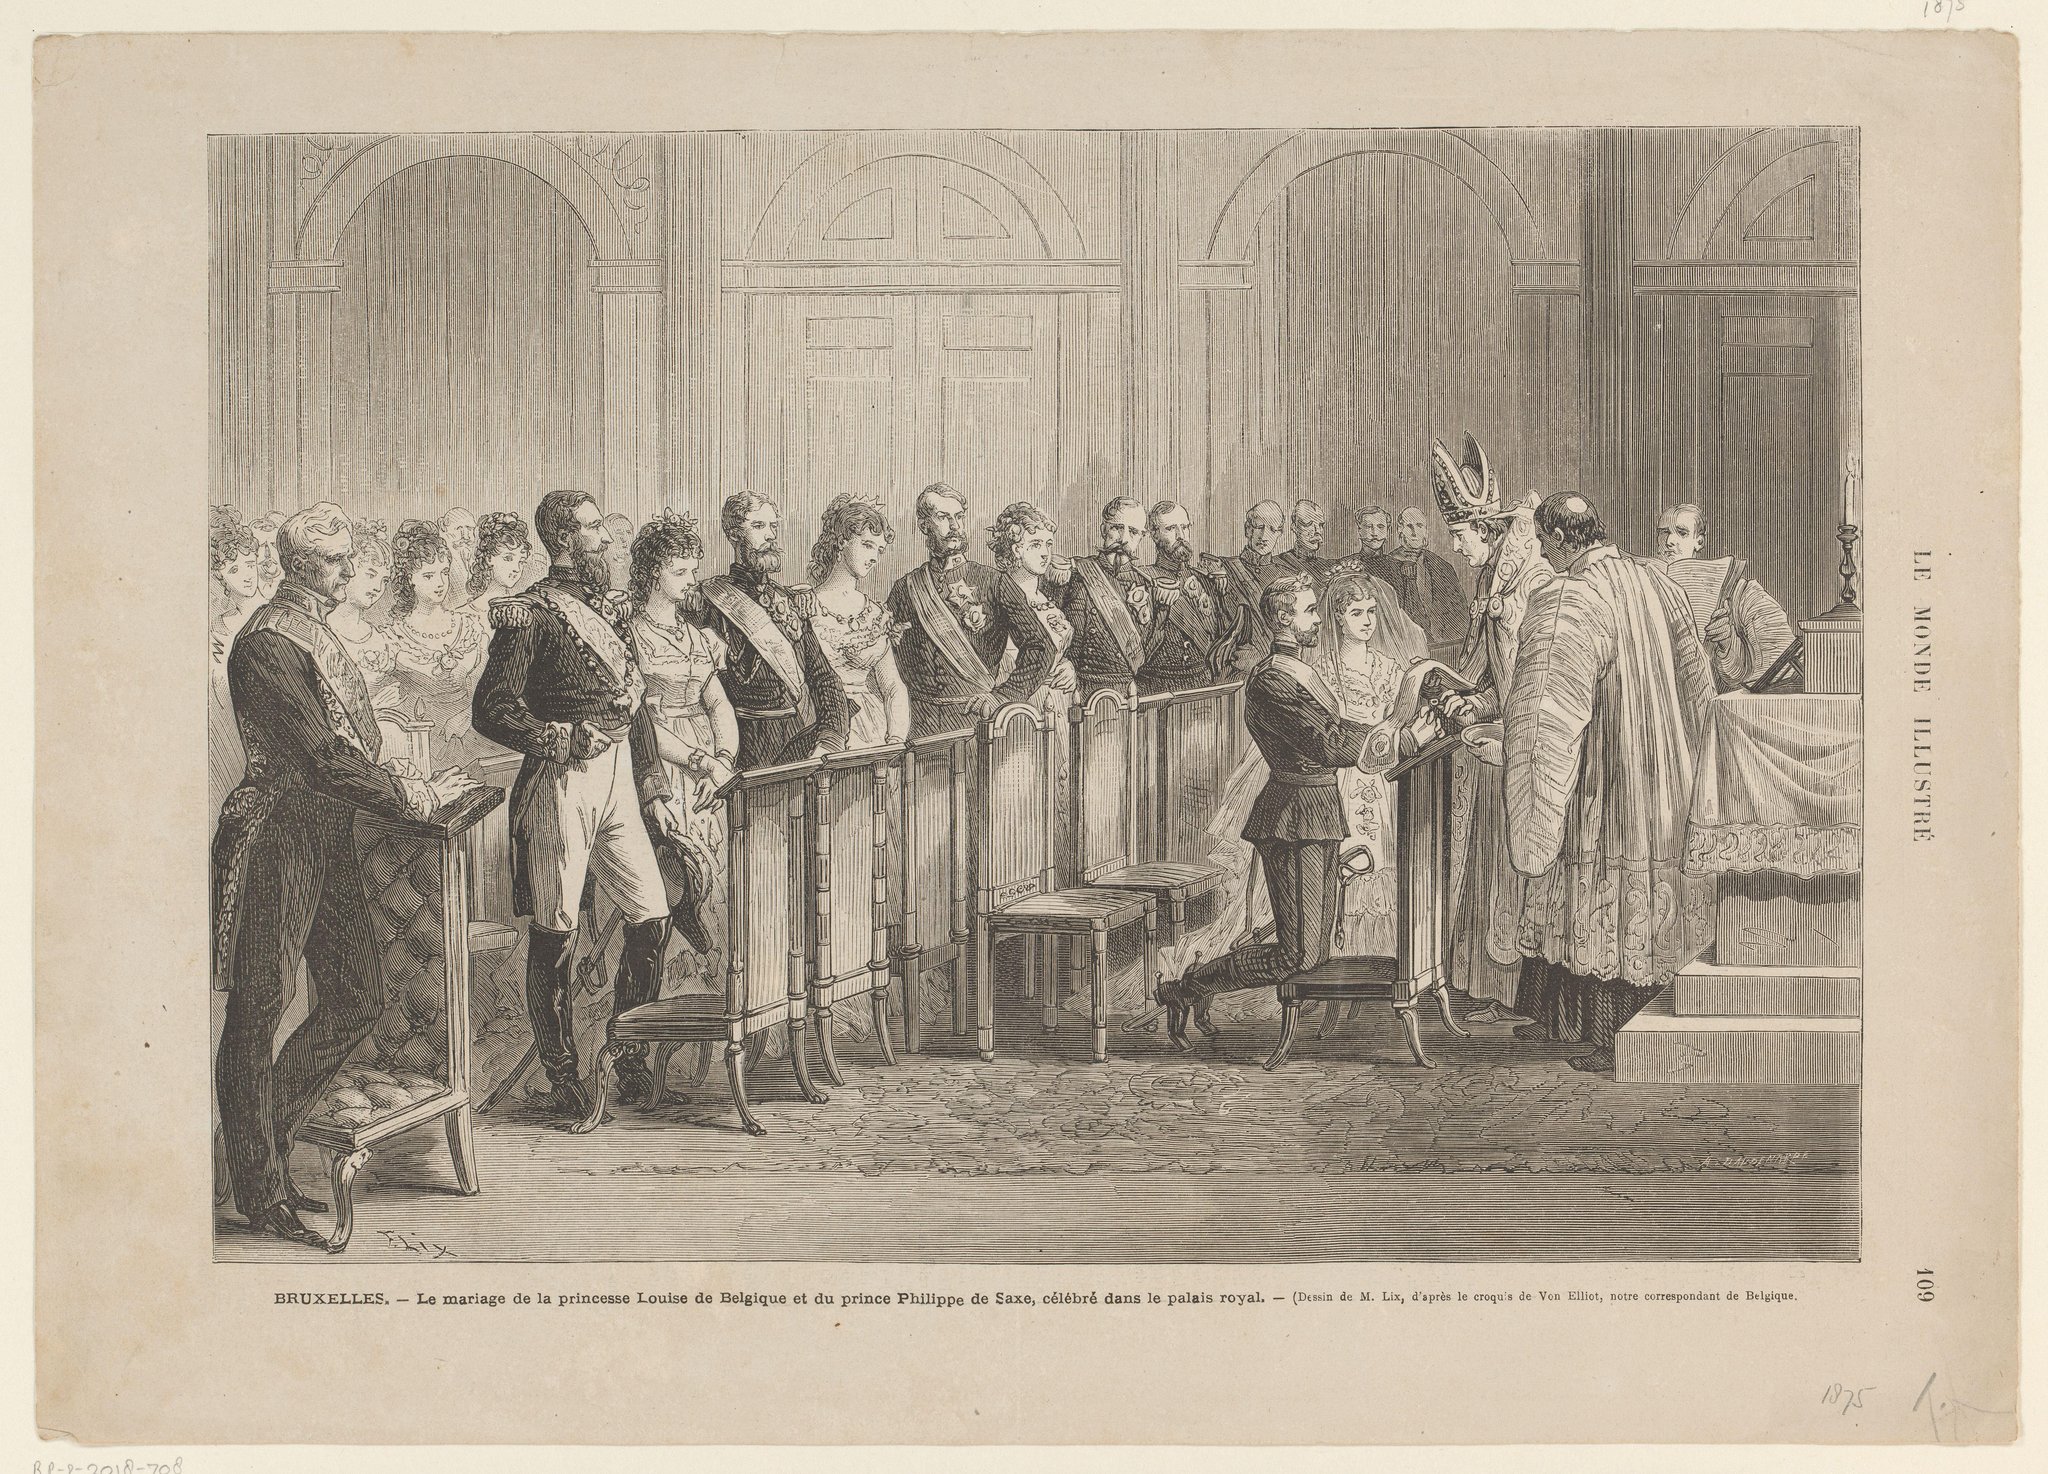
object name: book illustration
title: Huwelijk van prinses Louise van België, 1875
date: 1875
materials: paper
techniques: engraving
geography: france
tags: marriage in church ~ the sixth of the seven sacraments, brussels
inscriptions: collector's mark: Lugt 2228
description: Huwelijk van prinses Louise van België met prins Filips van Saksen-Coburg-Gotha, 4 februari 1875, in het Koninklijk Paleis te Brussel.